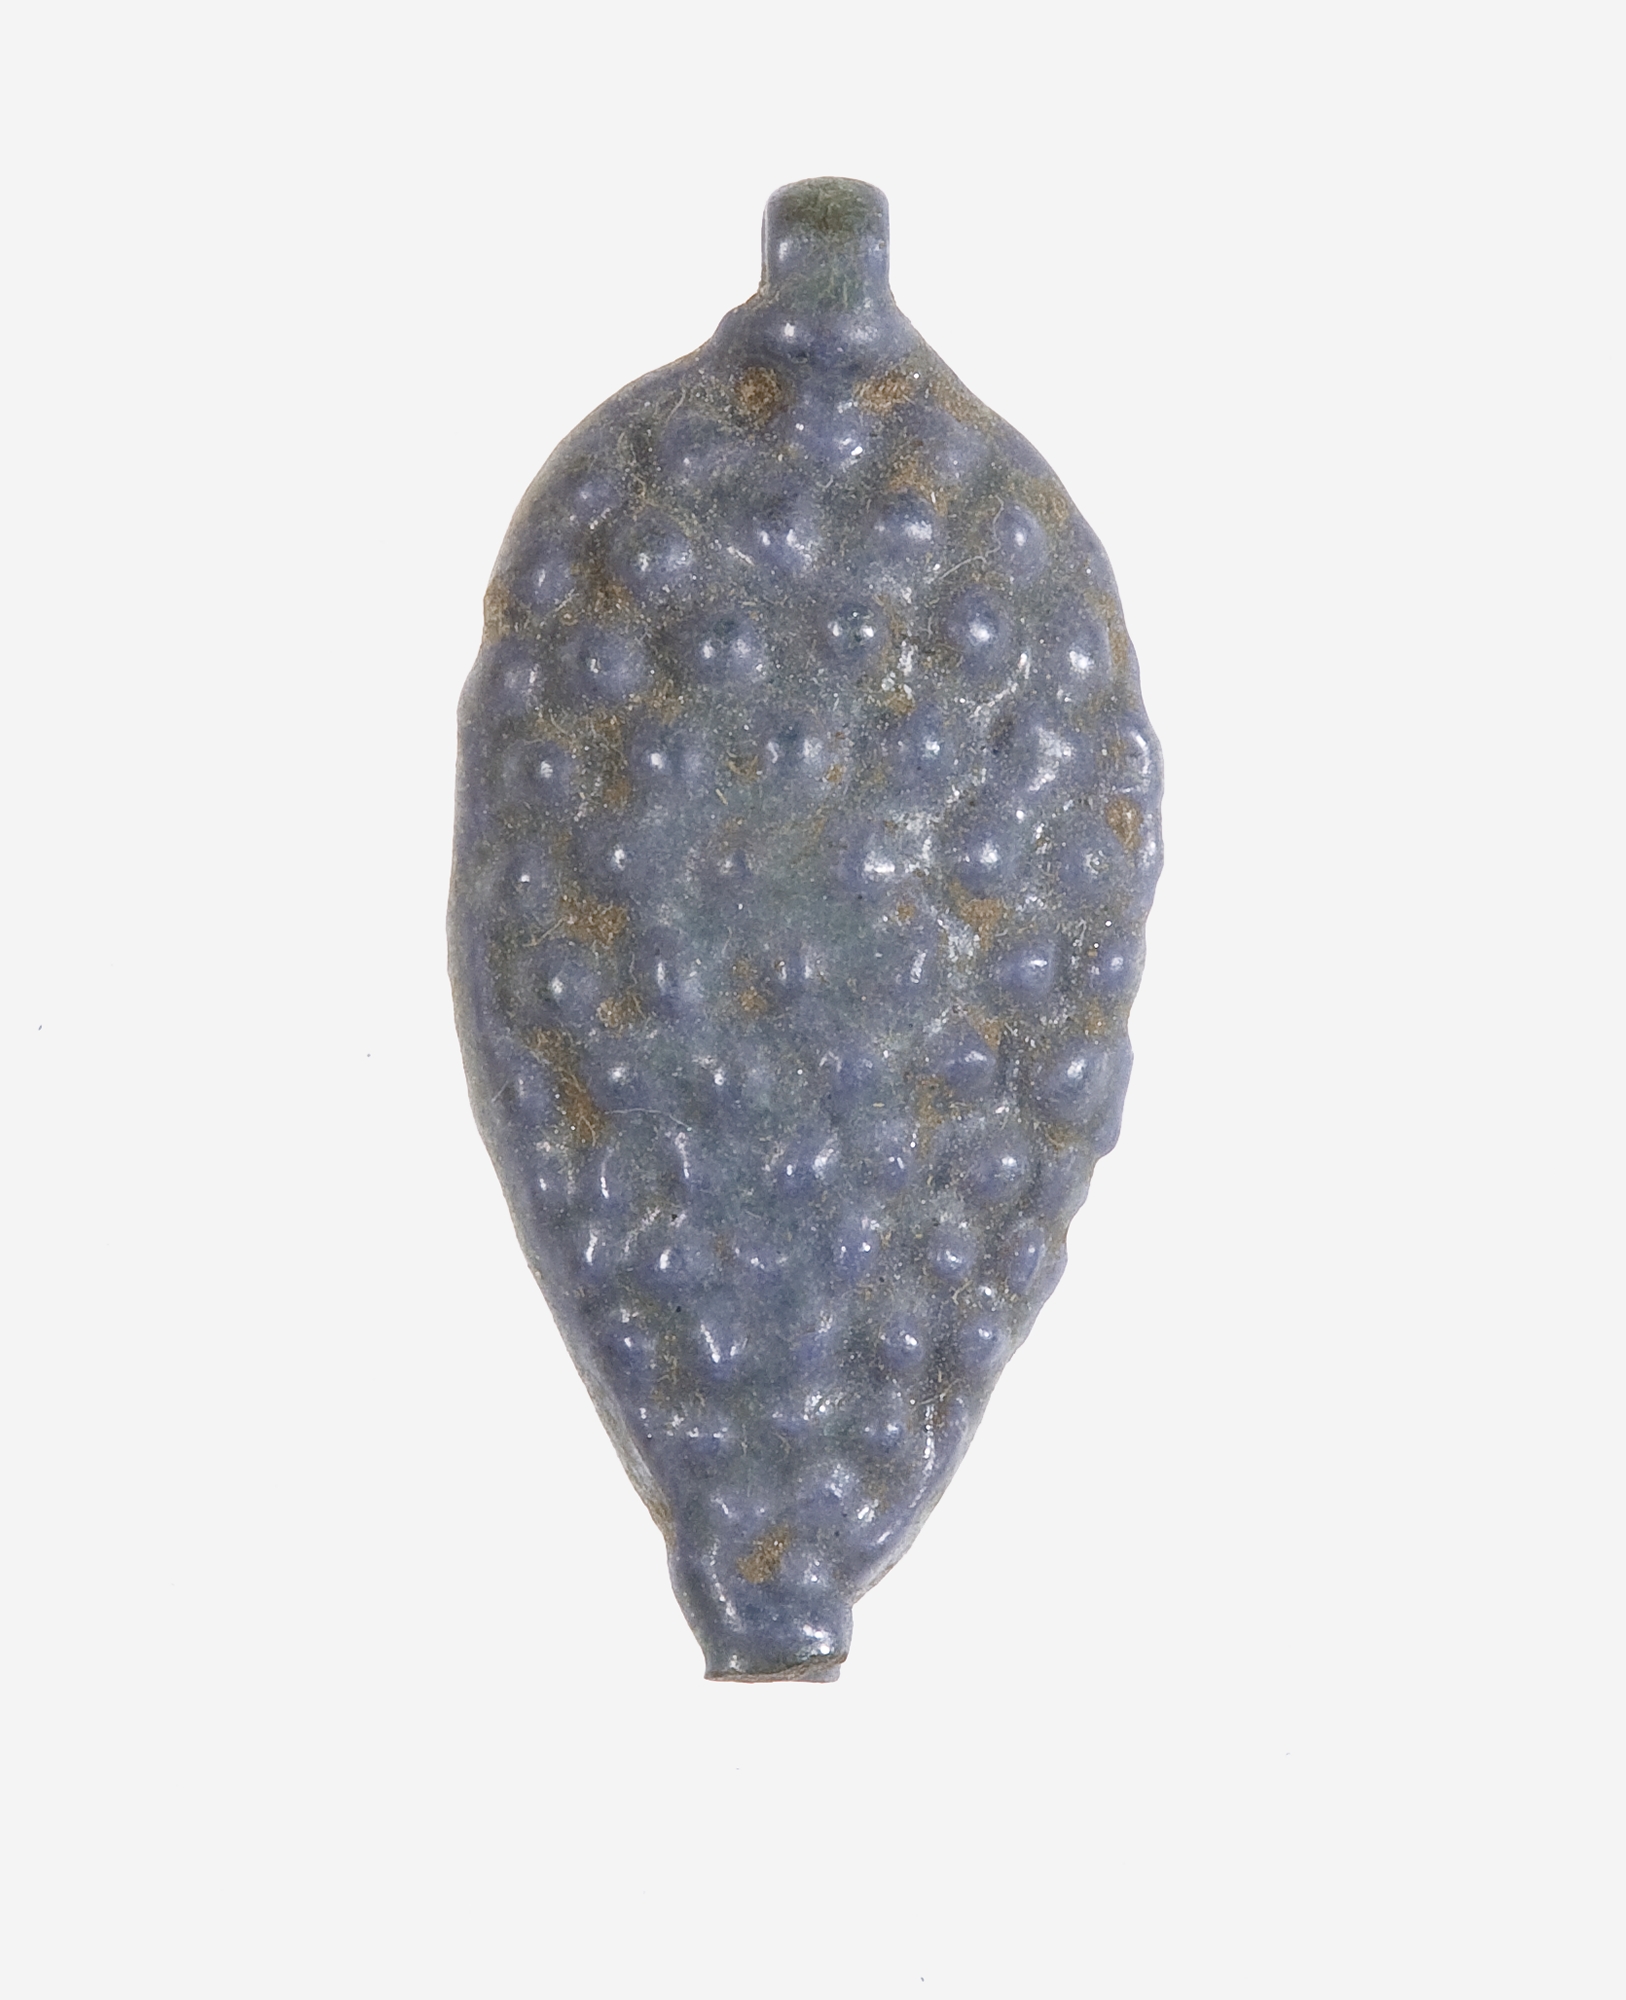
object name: pendant, grape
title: Pendant: Bunch of Grapes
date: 1390-1352 BCE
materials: faience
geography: egypt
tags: grapes